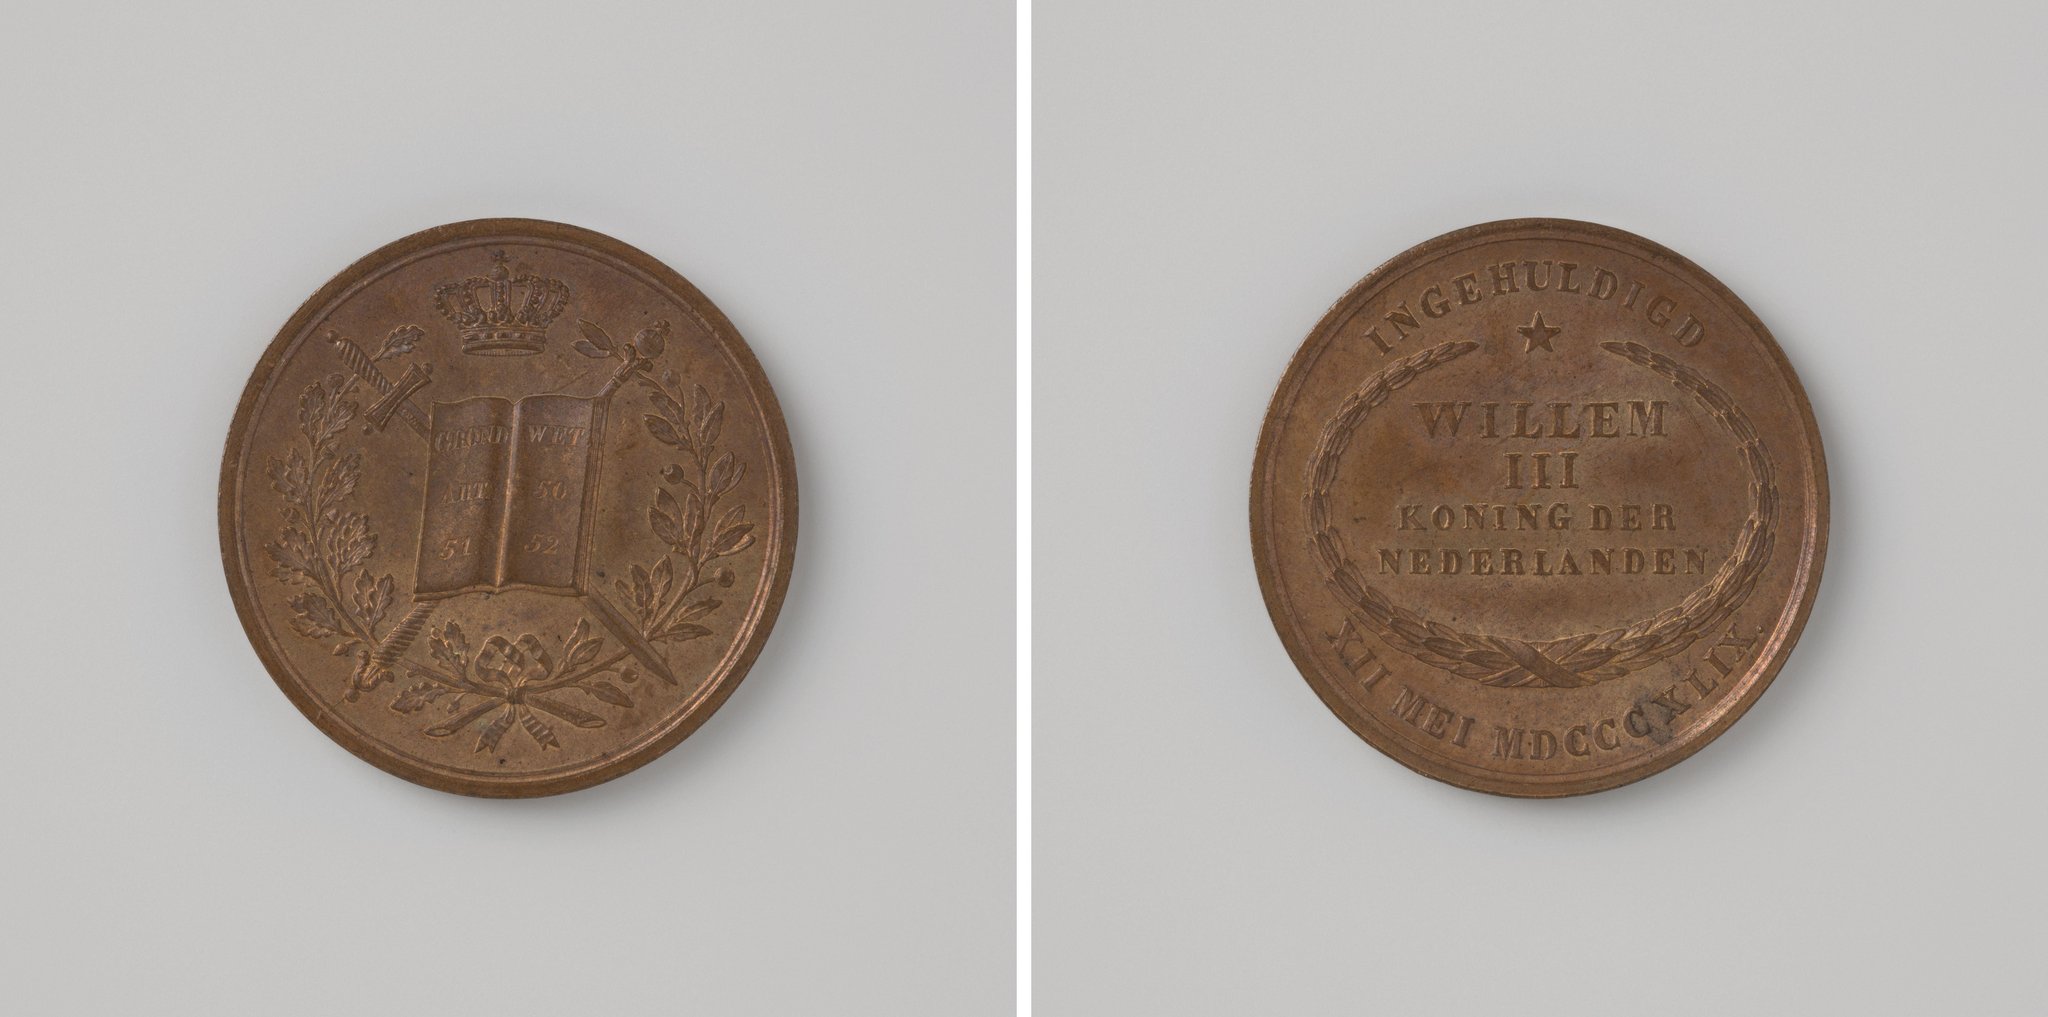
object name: history medal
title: Strooipenning bij de inhuldiging van Koning Willem III te Amsterdam 1849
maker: johannis petrus schouberg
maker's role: die cutter, draughtsman, print maker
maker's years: 1798-1864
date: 1849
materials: bronze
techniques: striking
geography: utrecht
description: Bronzen penning, op de voorzijde het boek der grondwet op gekruisd zwaard en scepter onder een kroon tussen een samengestrikte eiken- en lauwertak, op de keerzijde vier regels tekst binnen een lauwerdiadeem, met omschrift.